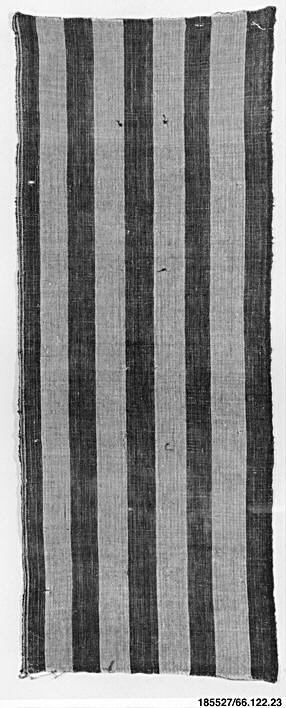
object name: length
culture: japanese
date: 1801-1900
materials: cotton